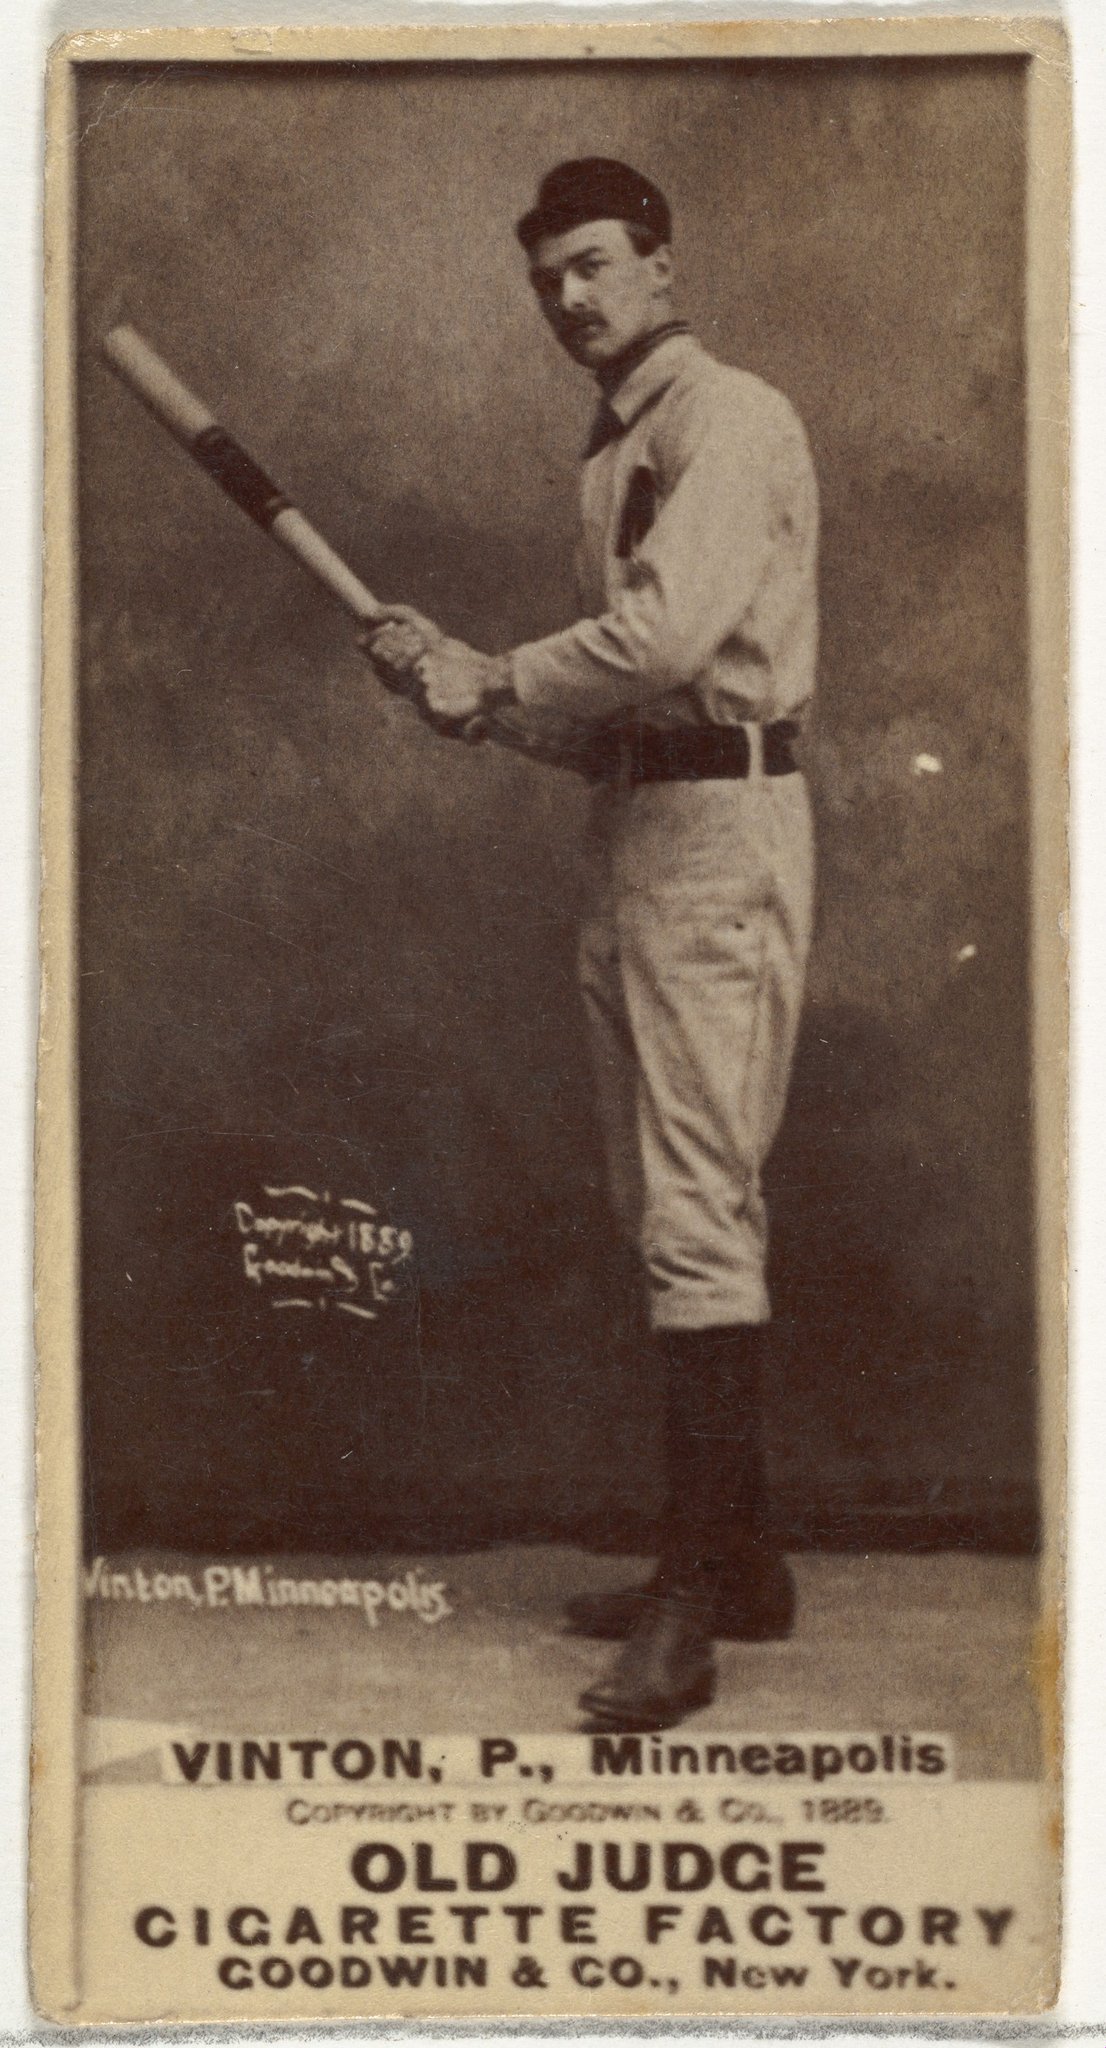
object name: baseball card, photograph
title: William Miller "Bill" Vinton, Pitcher, Minneapolis, from the Old Judge series (N172) for Old Judge Cigarettes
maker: goodwin & company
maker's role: publisher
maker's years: 1850-1950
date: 1889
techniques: albumen silver print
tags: men,portraits,baseball,athletes